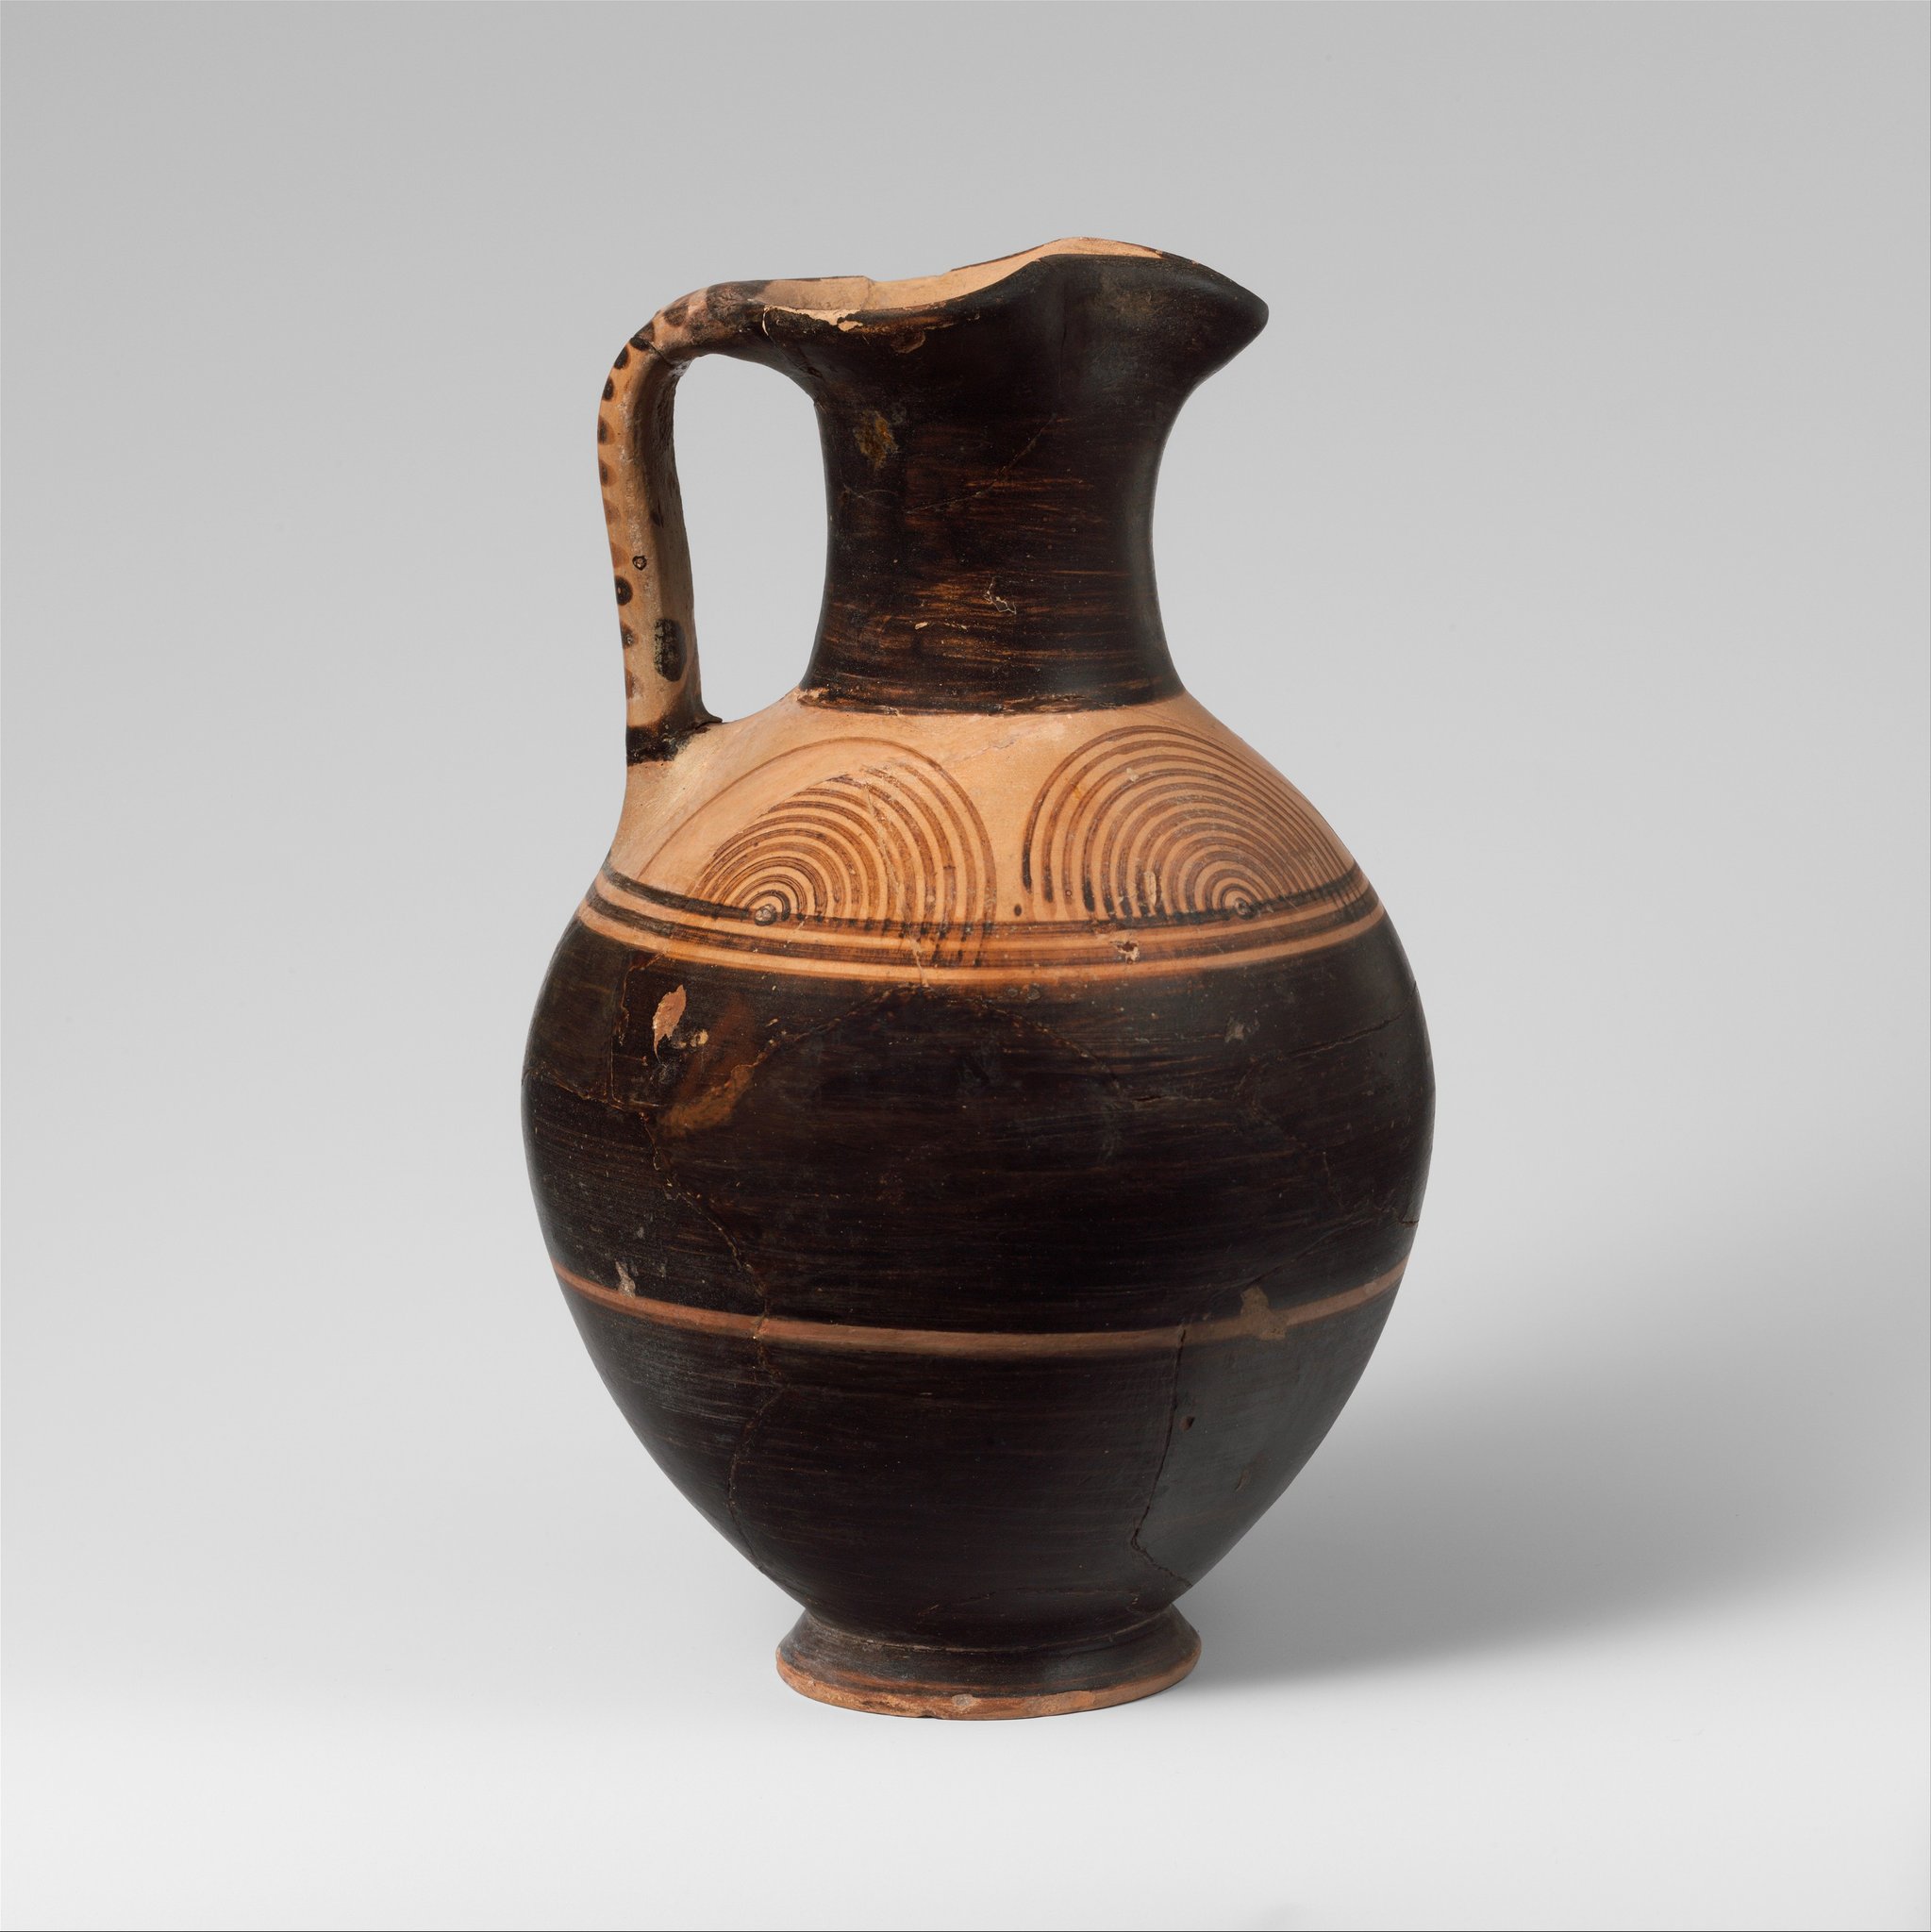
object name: oinochoe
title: Terracotta oinochoe (jug)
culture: greek, attic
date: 934-868 BCE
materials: terracotta